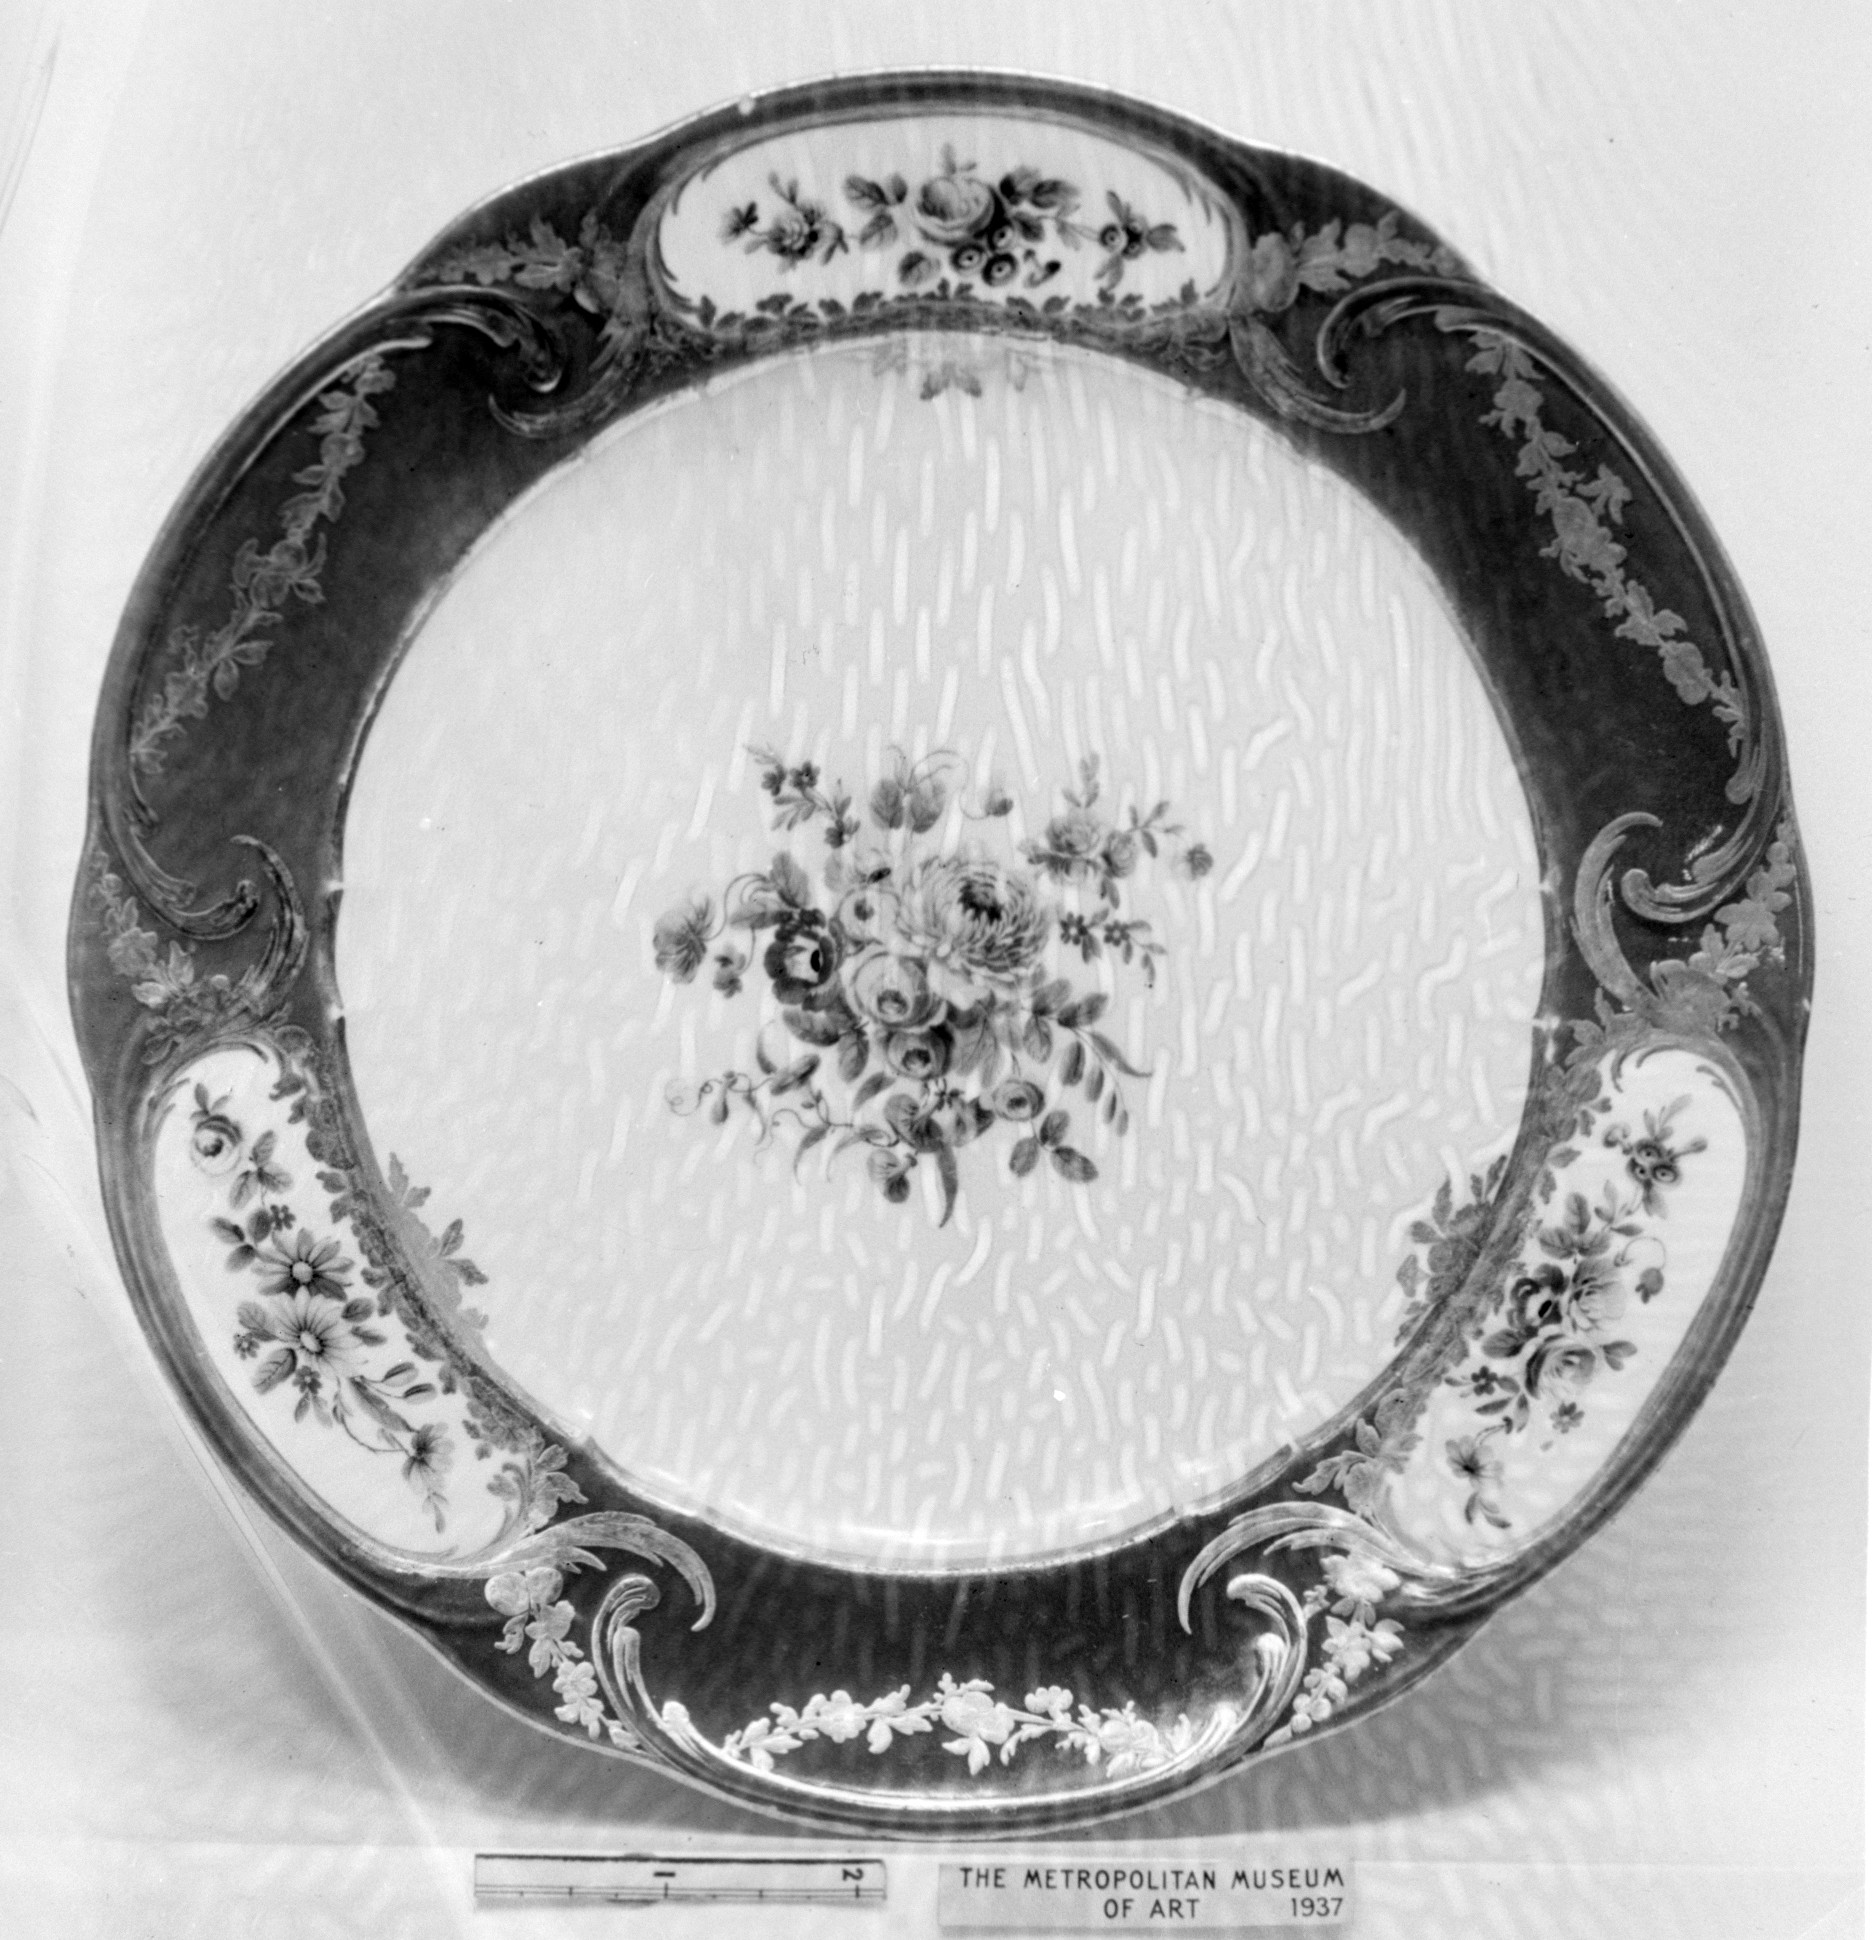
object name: plate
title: Plate (part of a service)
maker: sèvres manufactory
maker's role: manufactory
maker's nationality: french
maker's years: 1740-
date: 1765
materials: hard paste porcelain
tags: flowers